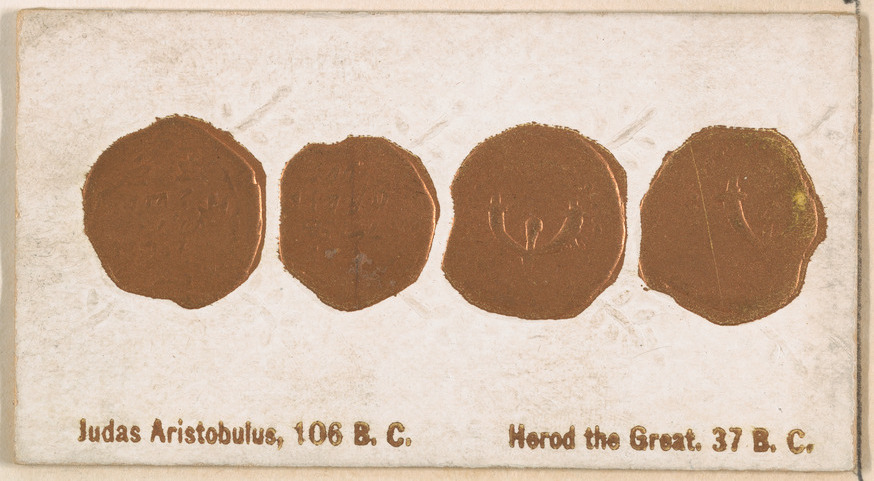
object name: print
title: Judas Aristobulus, 106 B.C. / Herod the Great, 37 B.C., from the Ancient Coins series (N180) issued by Wm. S. Kimball & Co.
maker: william s. kimball & company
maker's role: publisher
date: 1888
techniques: color lithograph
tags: coins